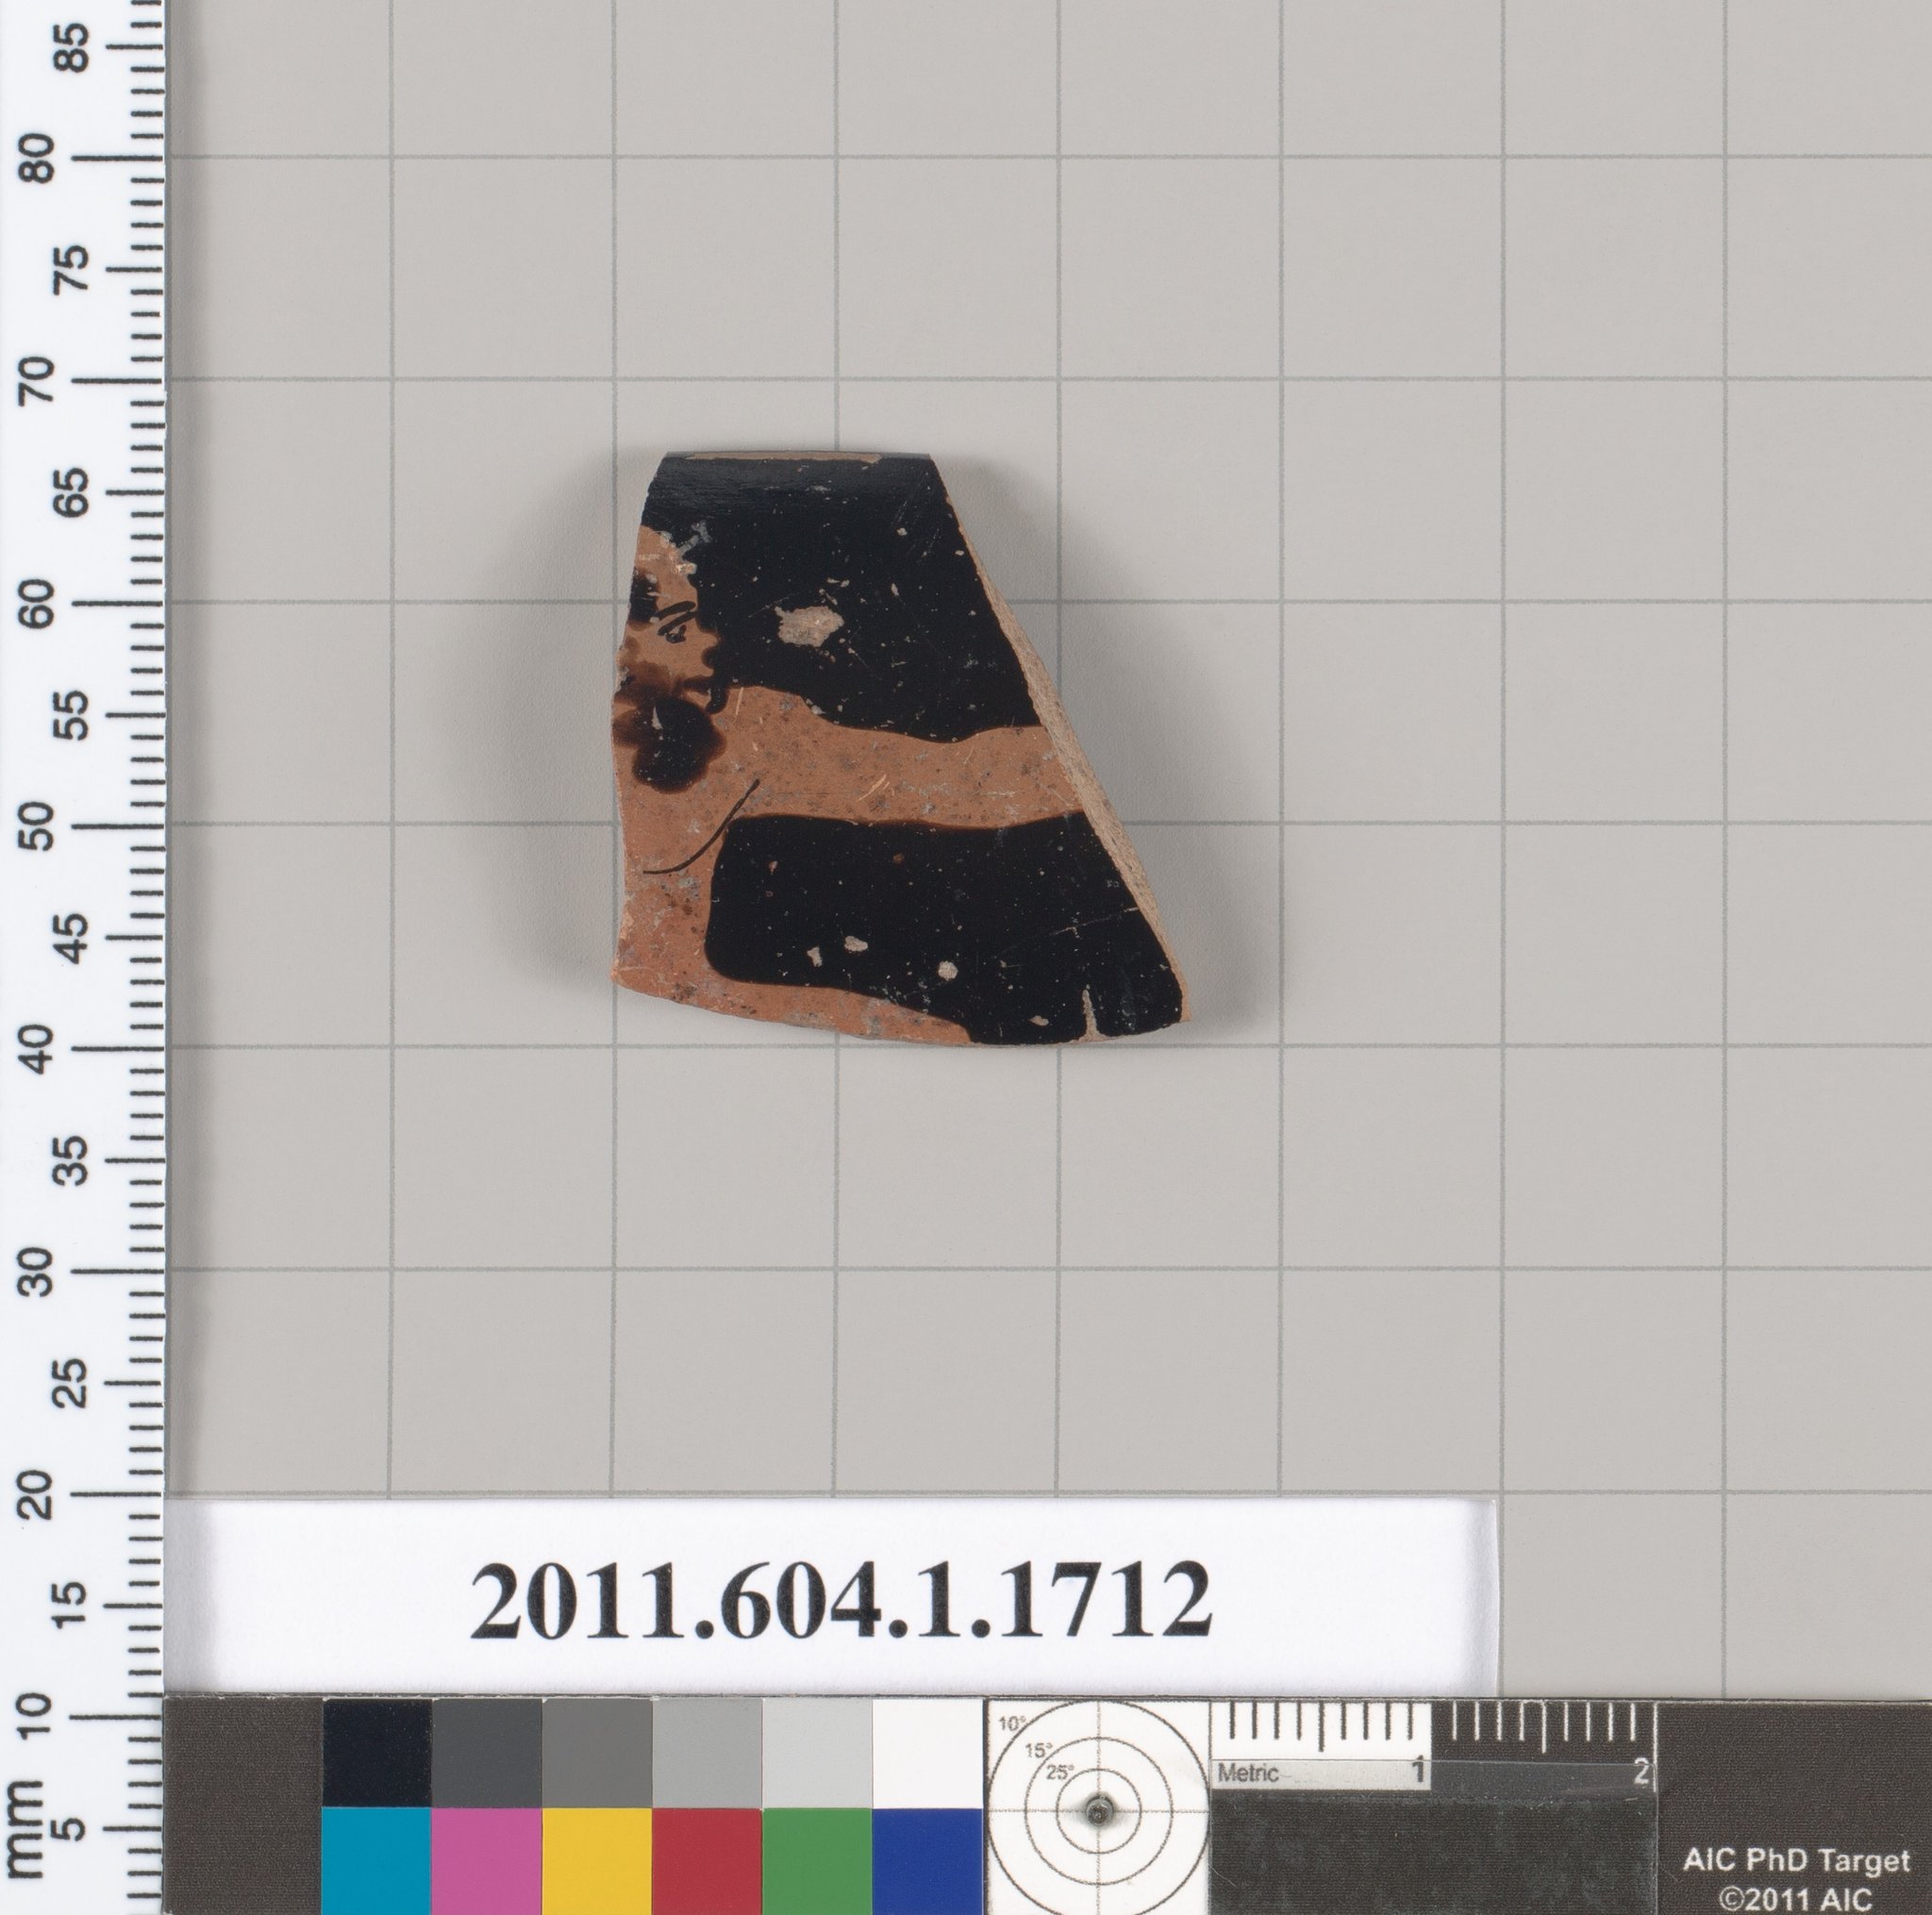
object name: kylix fragment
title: Terracotta rim fragment of a kylix (drinking cup)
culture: greek, attic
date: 467-435 BCE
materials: terracotta